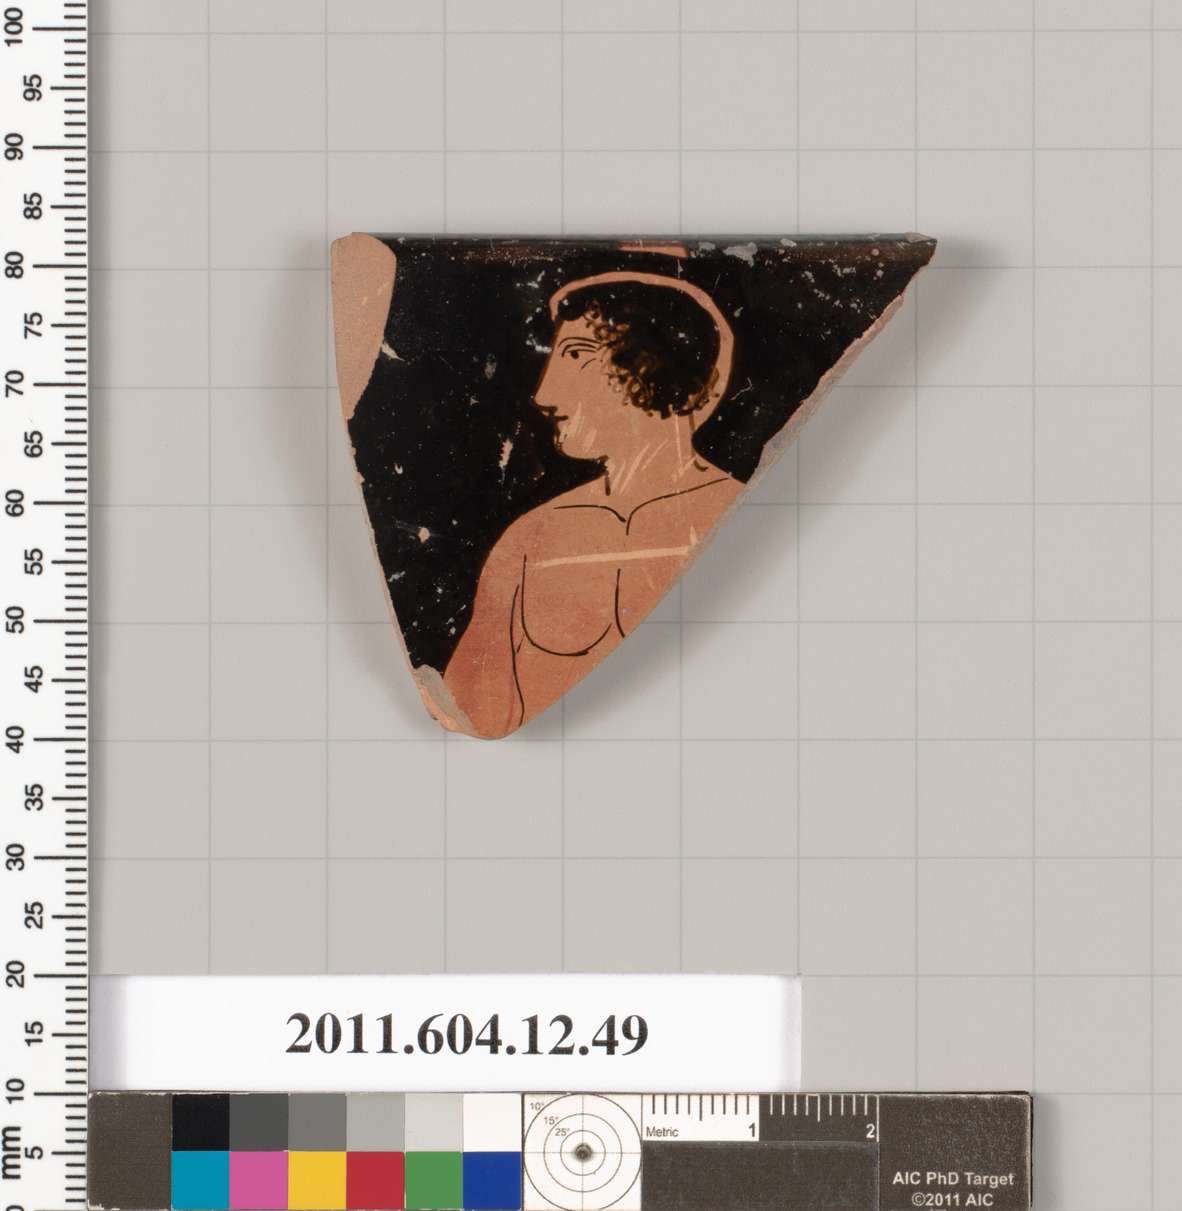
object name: skyphos fragment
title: Terracotta rim fragment of a skyphos (deep drinking cup)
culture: greek or south italian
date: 400-301 BCE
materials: terracotta